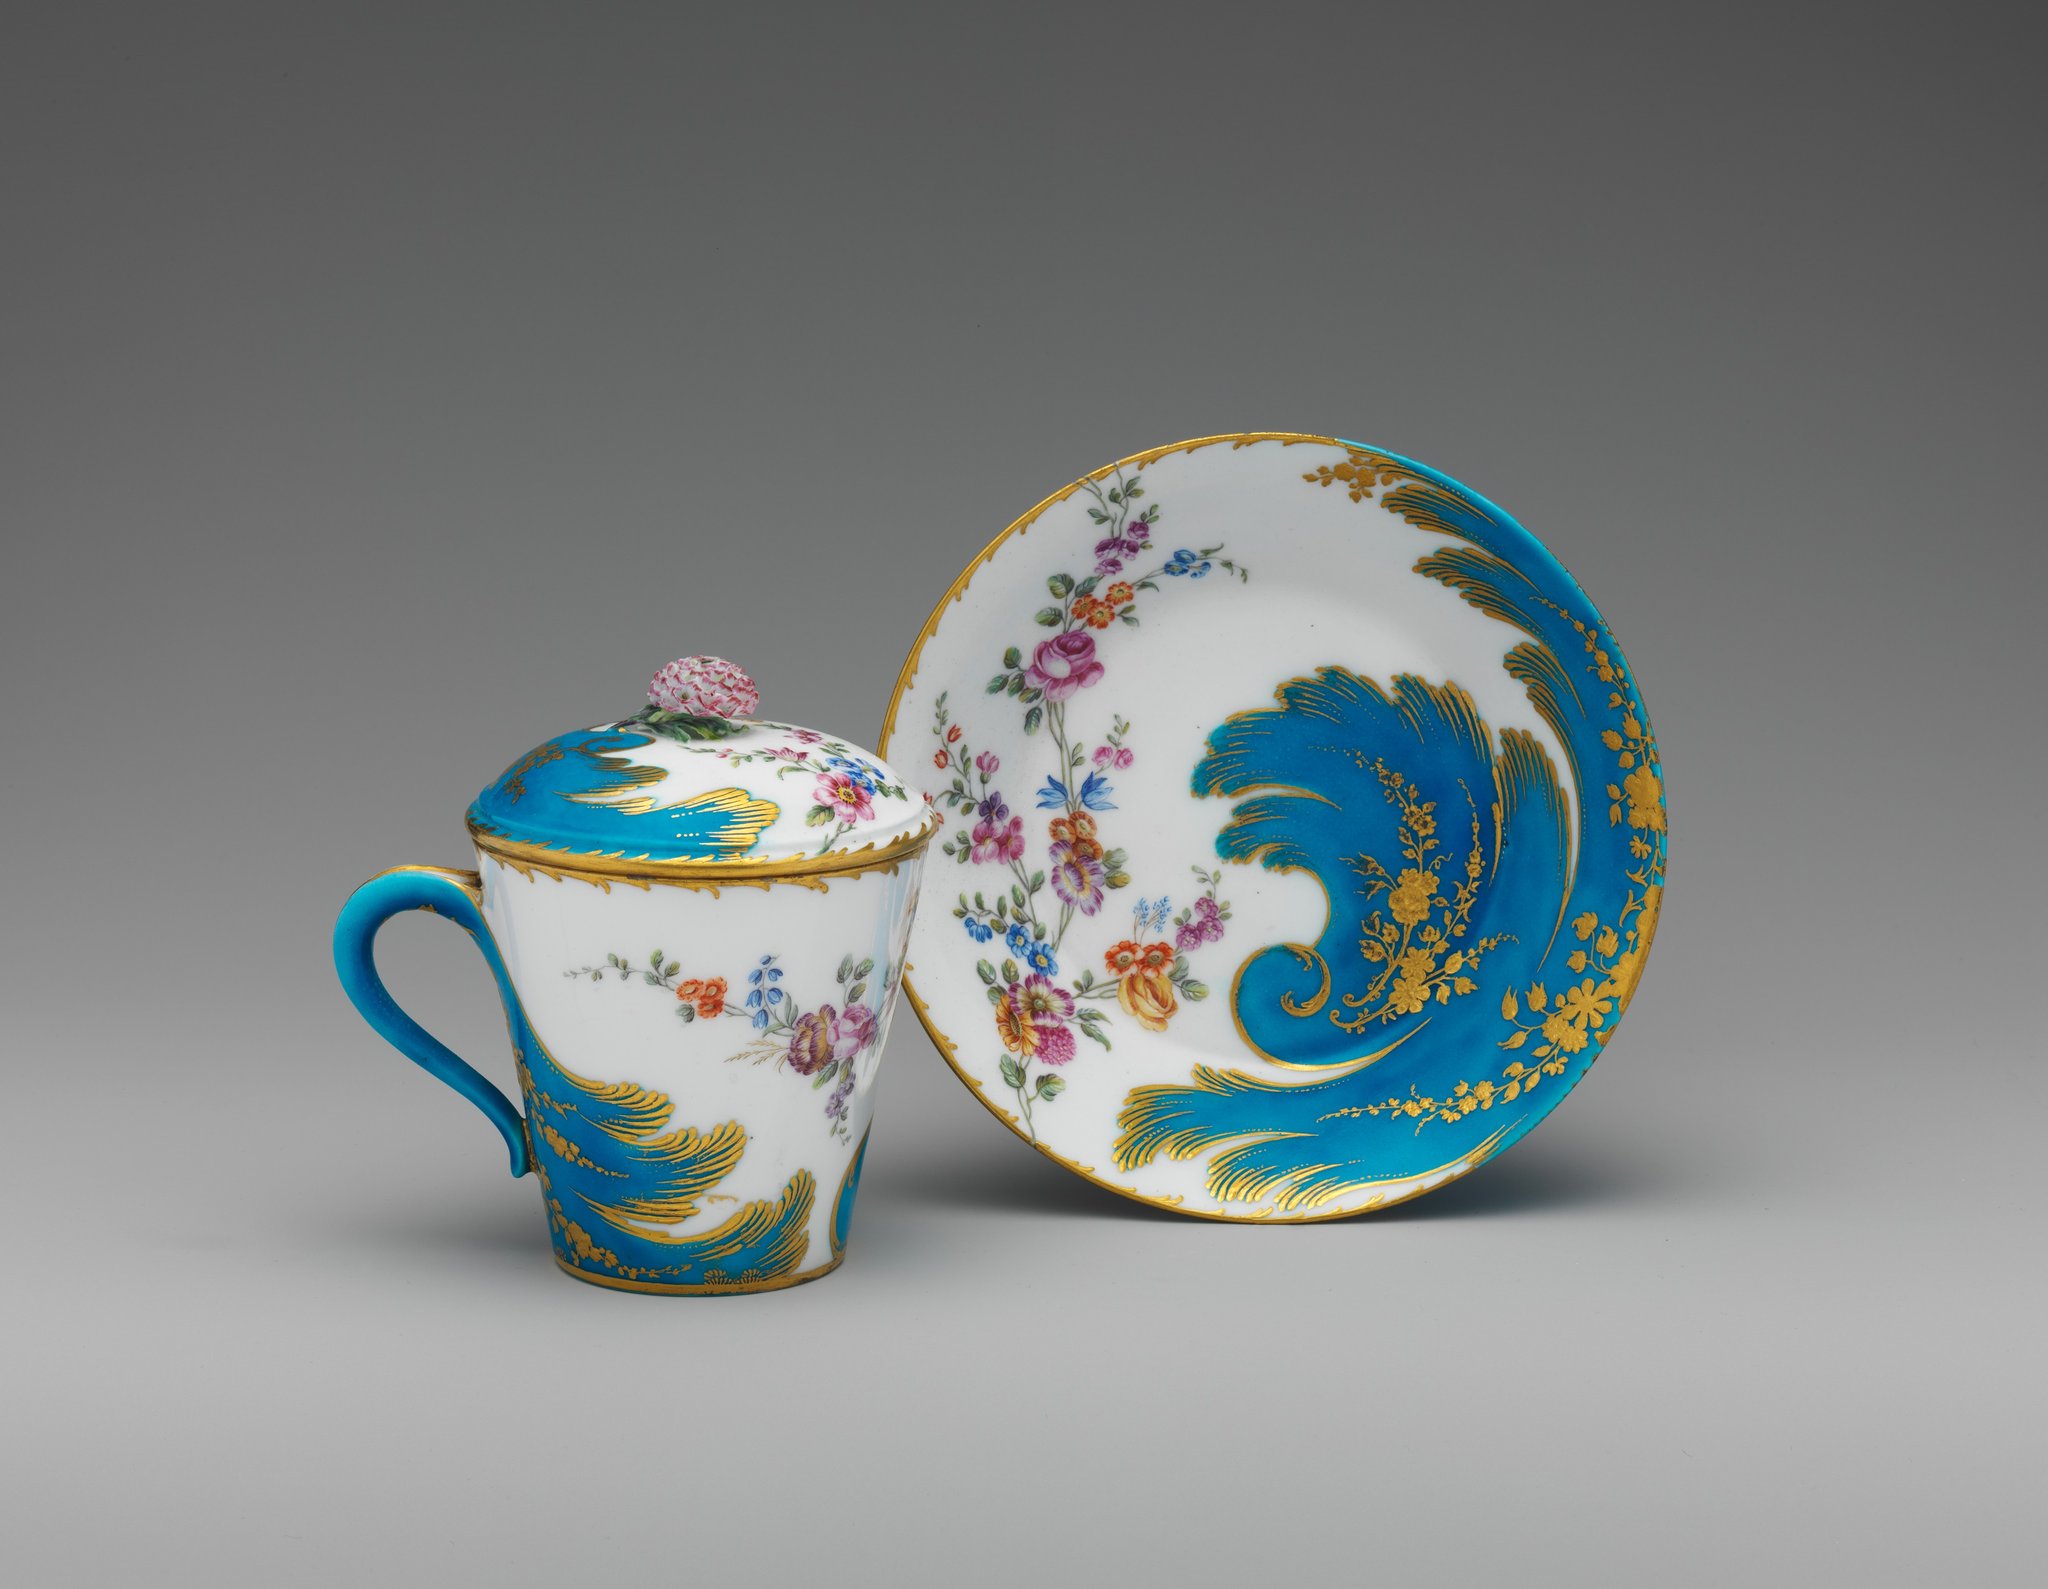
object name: cup and saucer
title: Cup with cover and saucer (gobelet à lait et soucoupe)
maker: vincennes manufactory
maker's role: manufactory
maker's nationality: french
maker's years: 1740-1756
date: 1756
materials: soft paste porcelain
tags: flowers